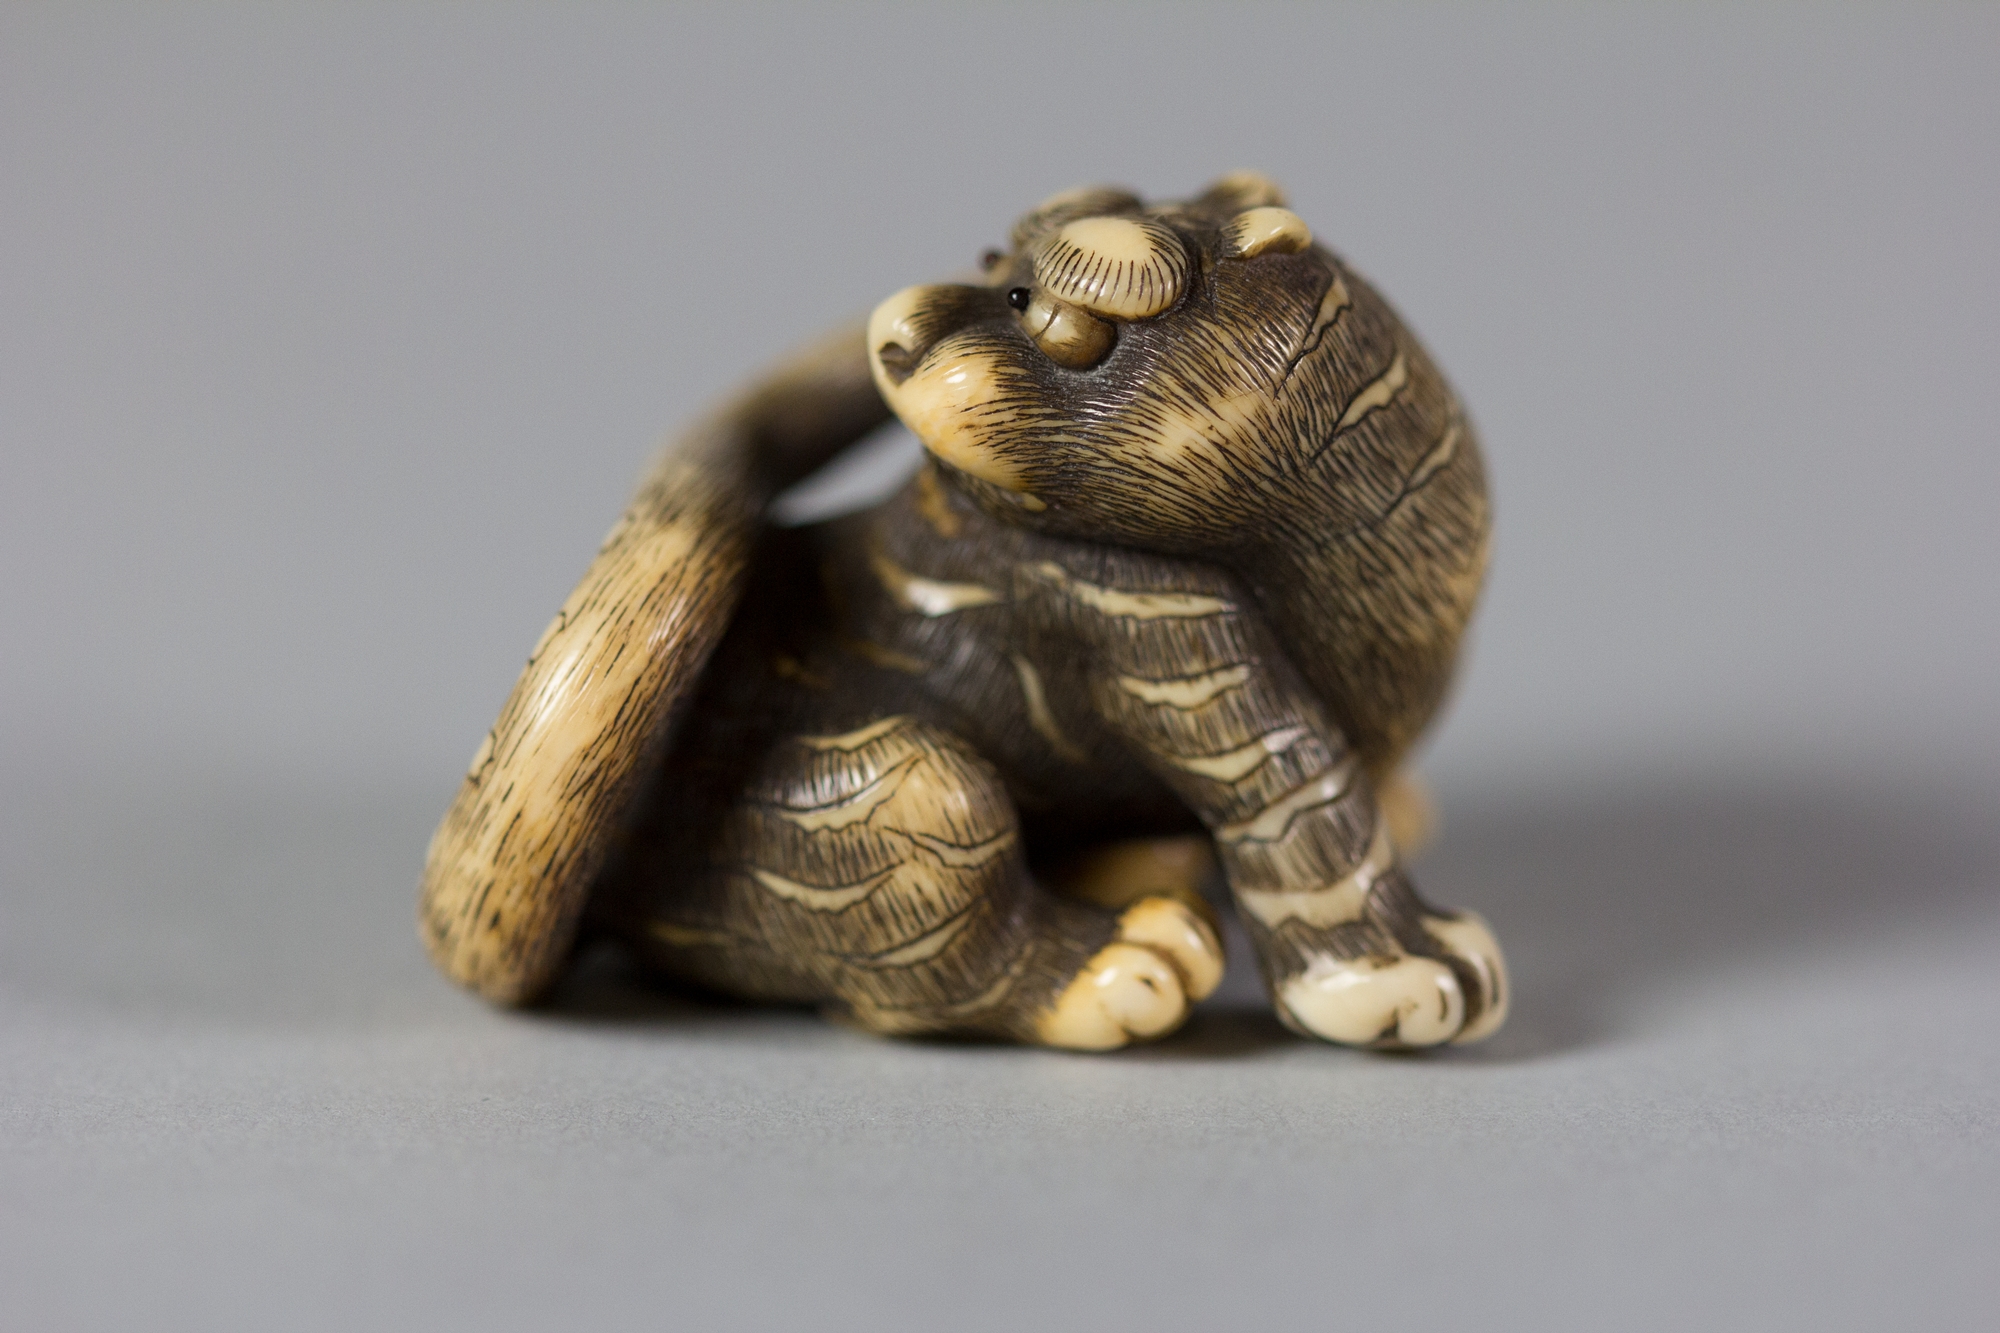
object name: netsuke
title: Tiger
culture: japanese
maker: raku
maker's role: artist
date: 1767-1800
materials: ivory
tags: tigers